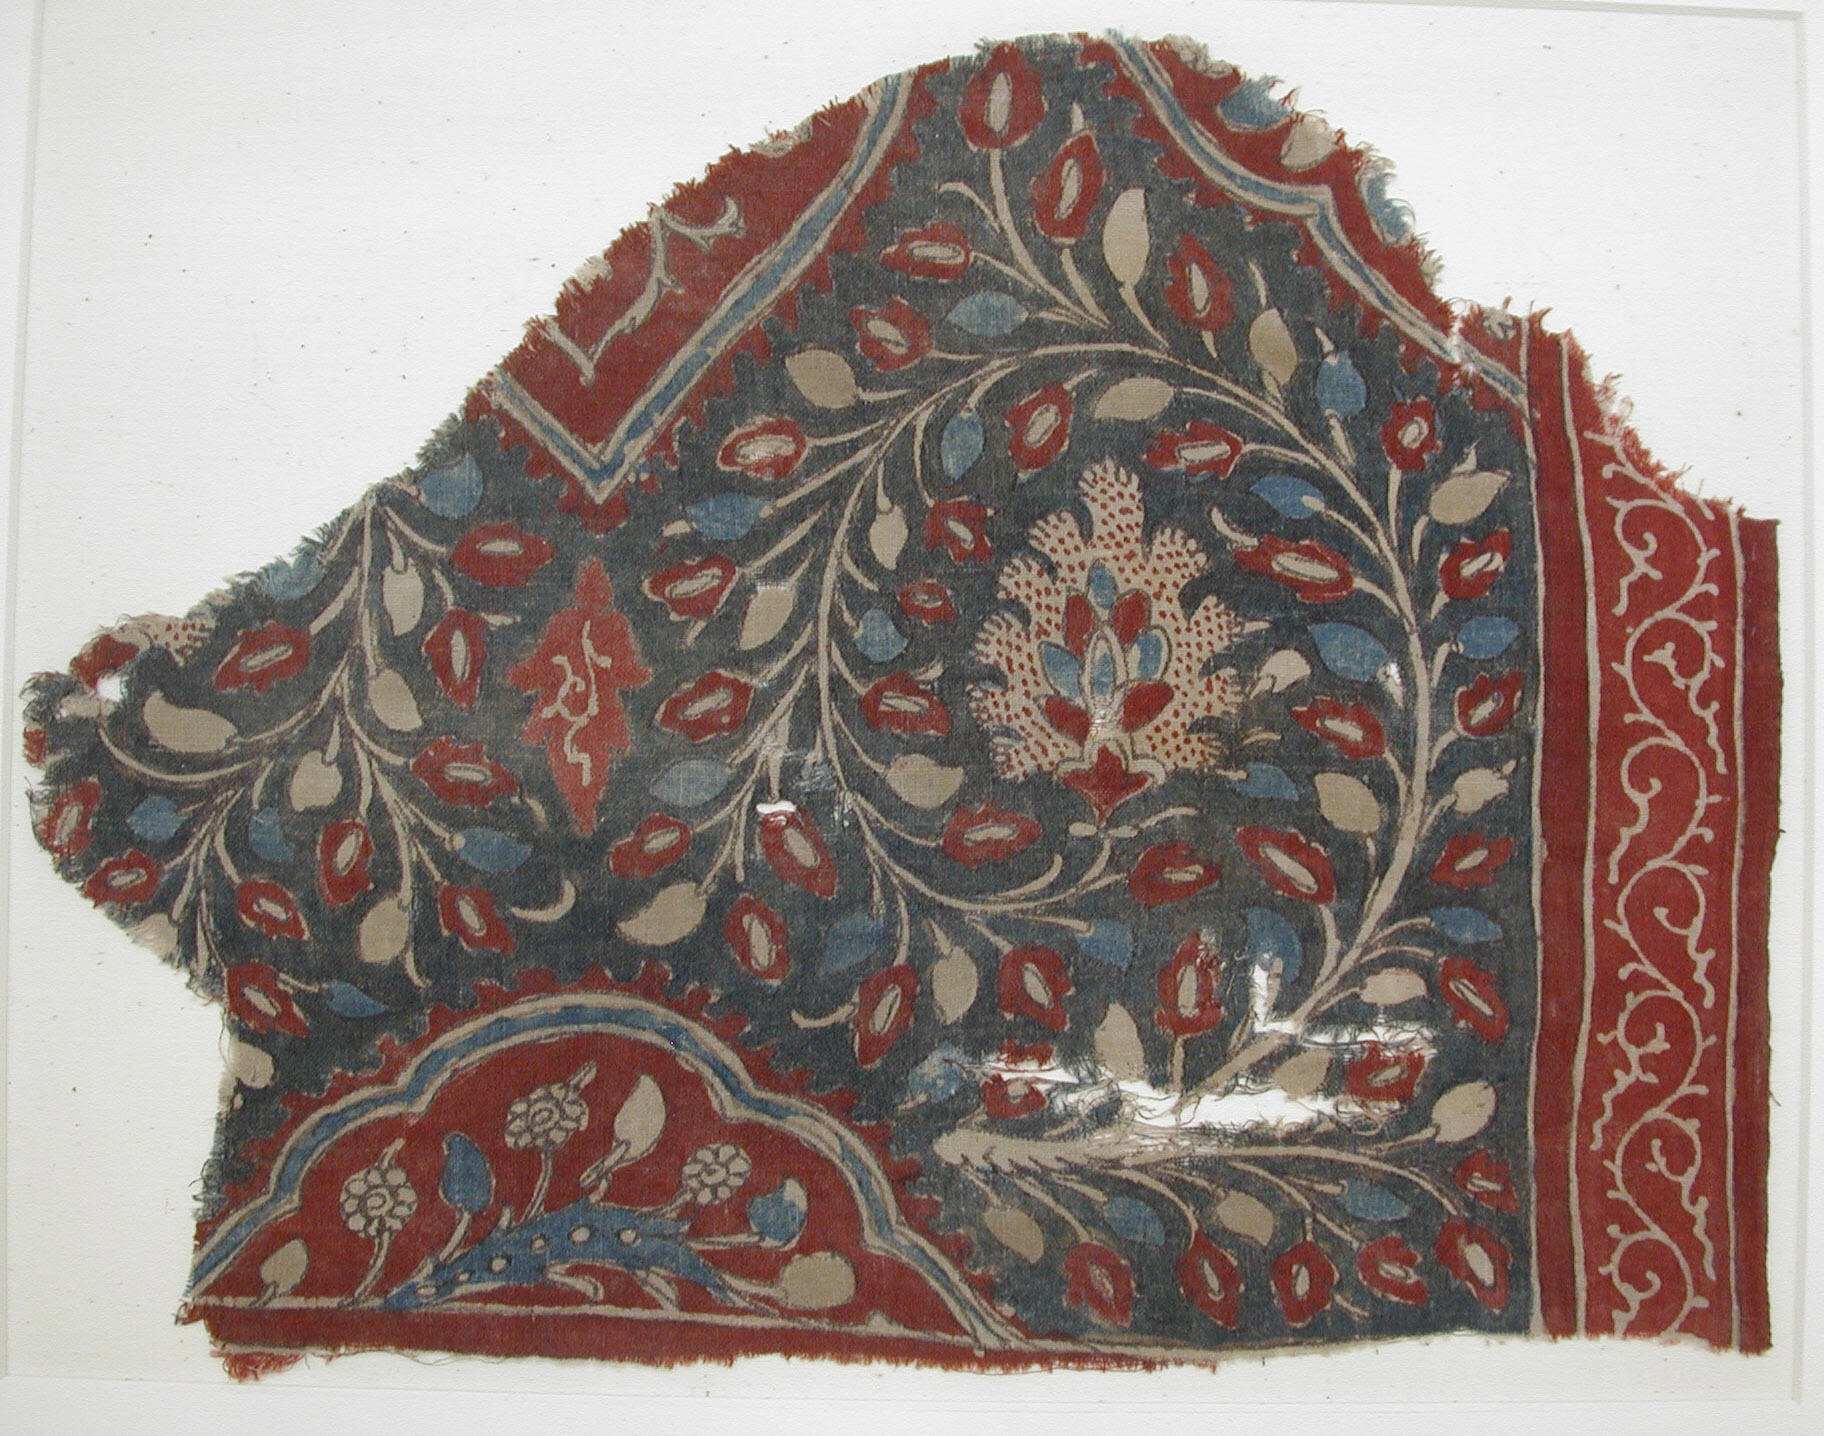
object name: textile fragment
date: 1501-1600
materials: cotton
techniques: dyeing, painting, weave, printing, resist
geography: egypt